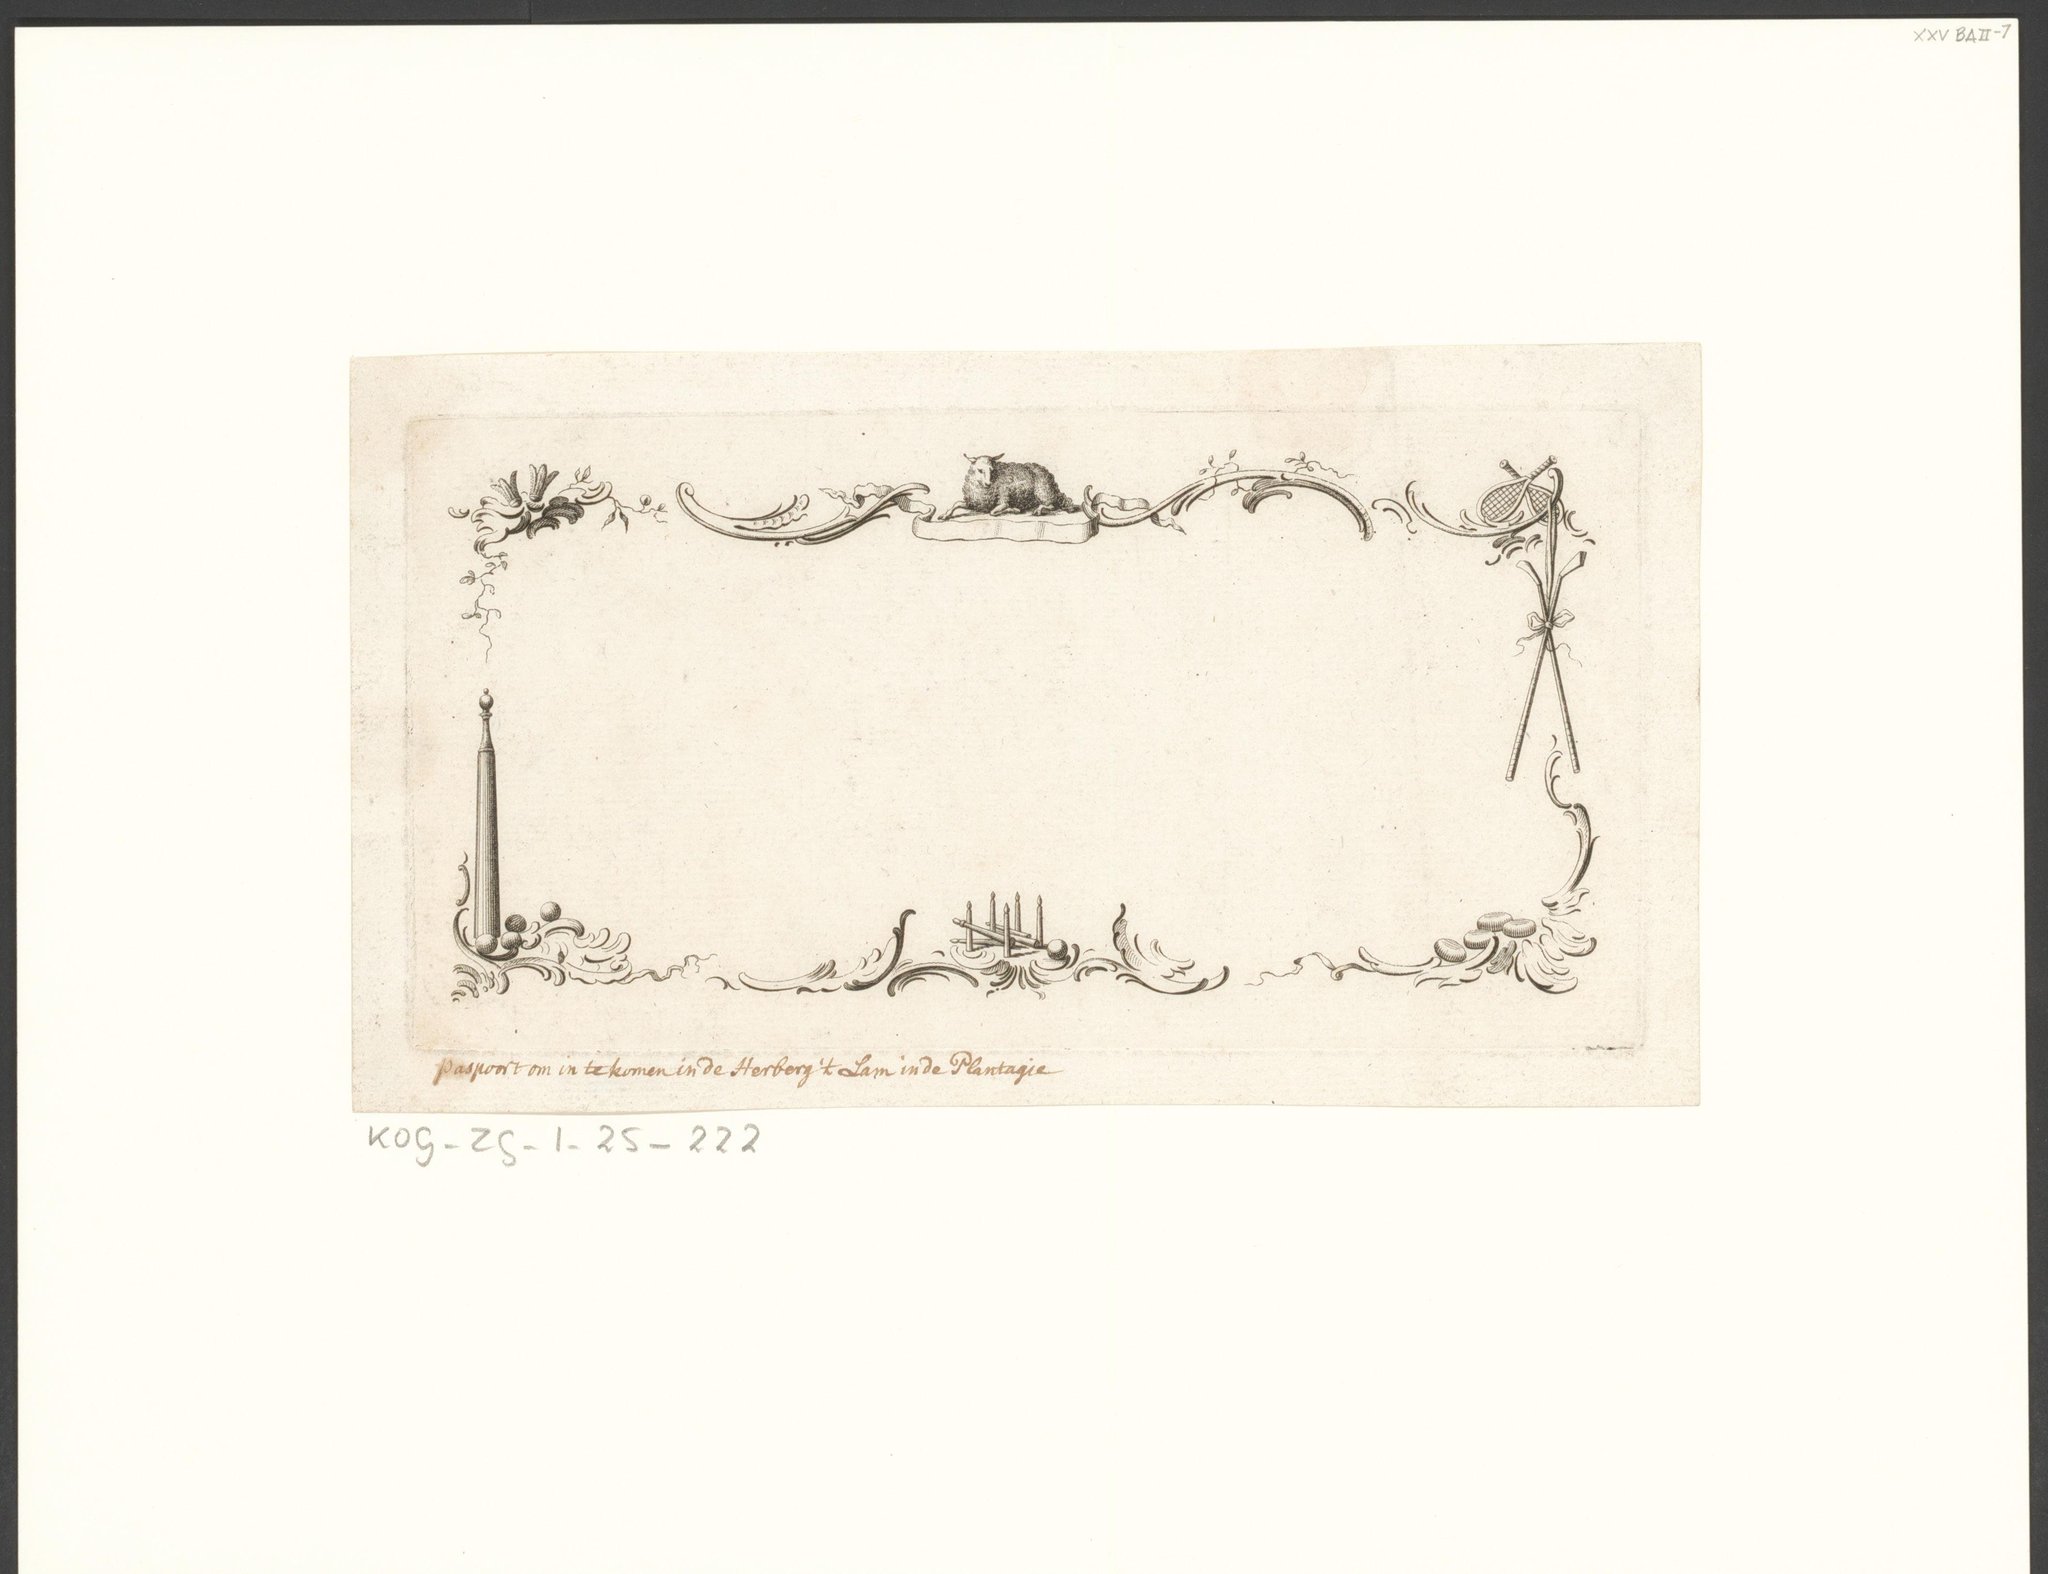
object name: print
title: Lijst met schaap en kegelspel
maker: Anonymous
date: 1700-1799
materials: paper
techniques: etching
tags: bowling games (children's games), sheep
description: Paspoort van herberg 't Lam in de Plantagie. Onderwerpsrubrieken binnen de Atlas Zeden en Gewoonten: Zeden en Gewoonten in Engeren Zin, Spel en vermaak, Oud-Hollandsch volksspel, Kegelen.